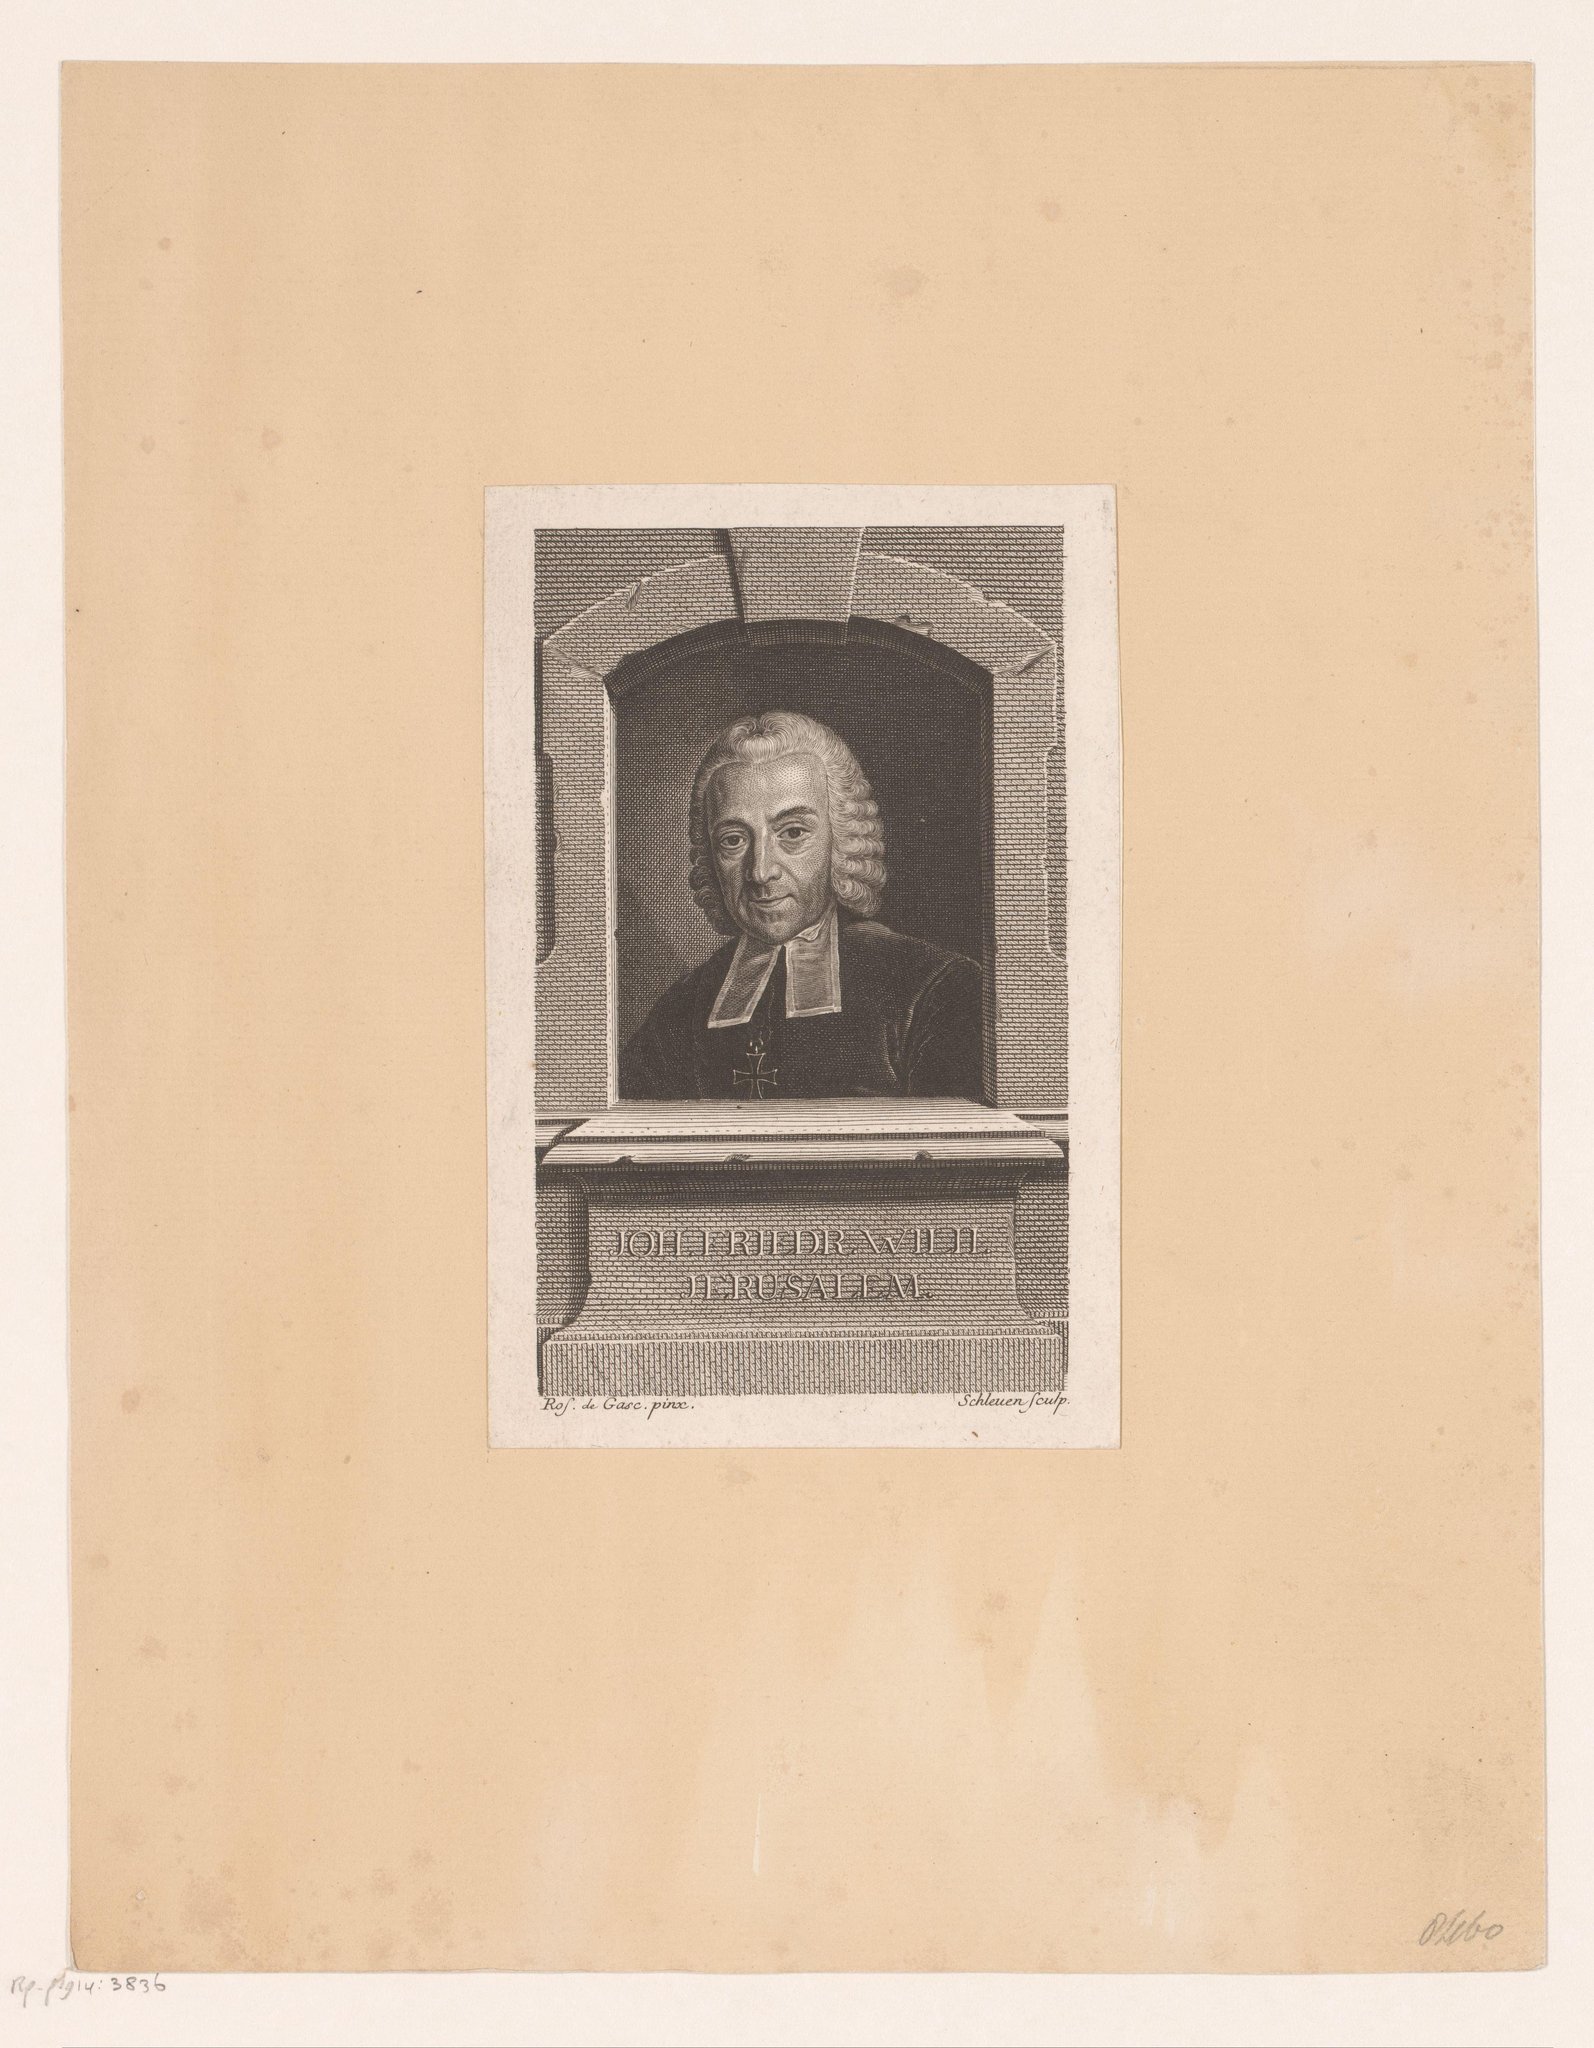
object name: print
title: Portret Johann Friedrich Wilhelm Jerusalem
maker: johann david schleuen (i)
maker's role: print maker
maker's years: 1711-1774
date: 1721-1771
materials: paper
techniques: engraving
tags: theologian, historical persons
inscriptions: collector's mark: Lugt 2228